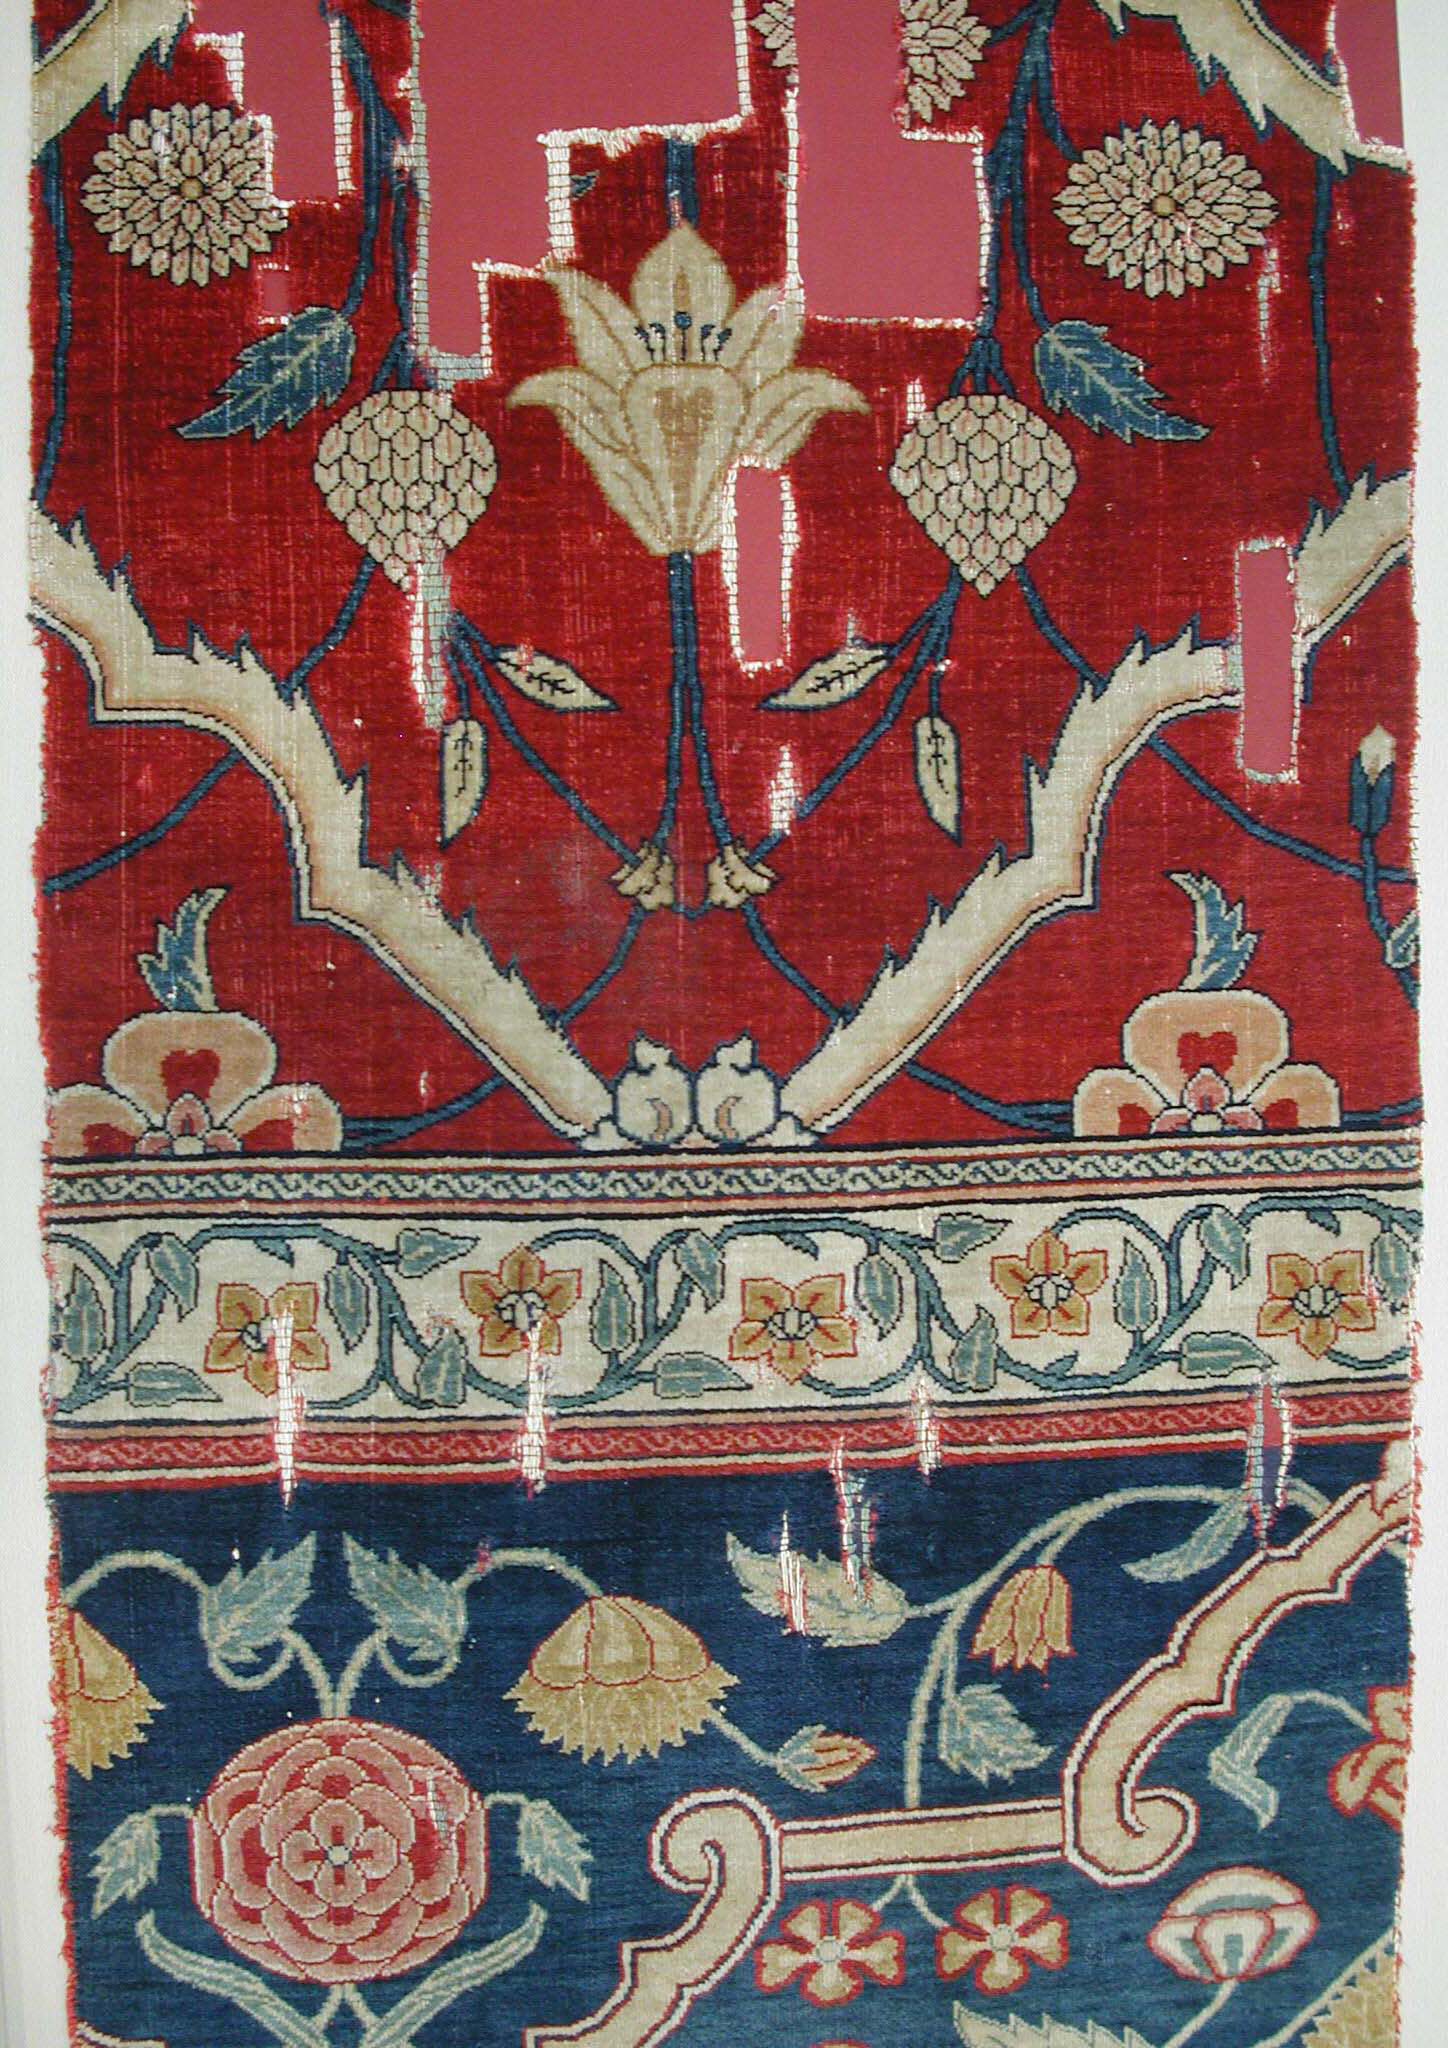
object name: textile fragment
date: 1651-1675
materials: silk, wool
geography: india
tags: flowers,leaves